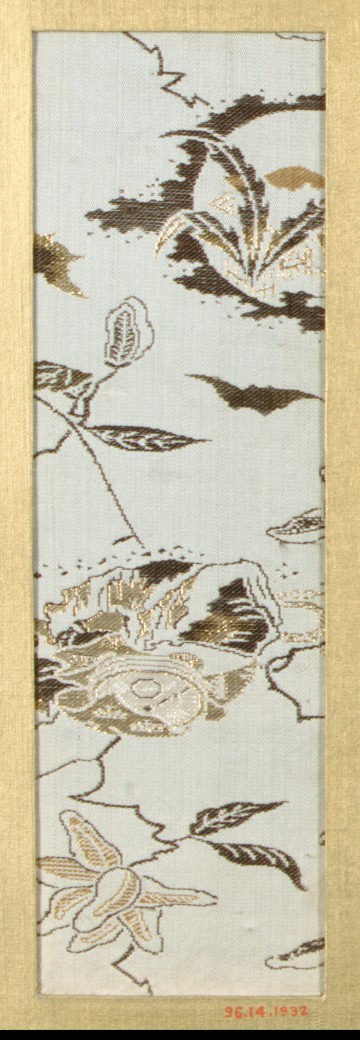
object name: piece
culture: japanese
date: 1701-1900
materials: silk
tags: leaves